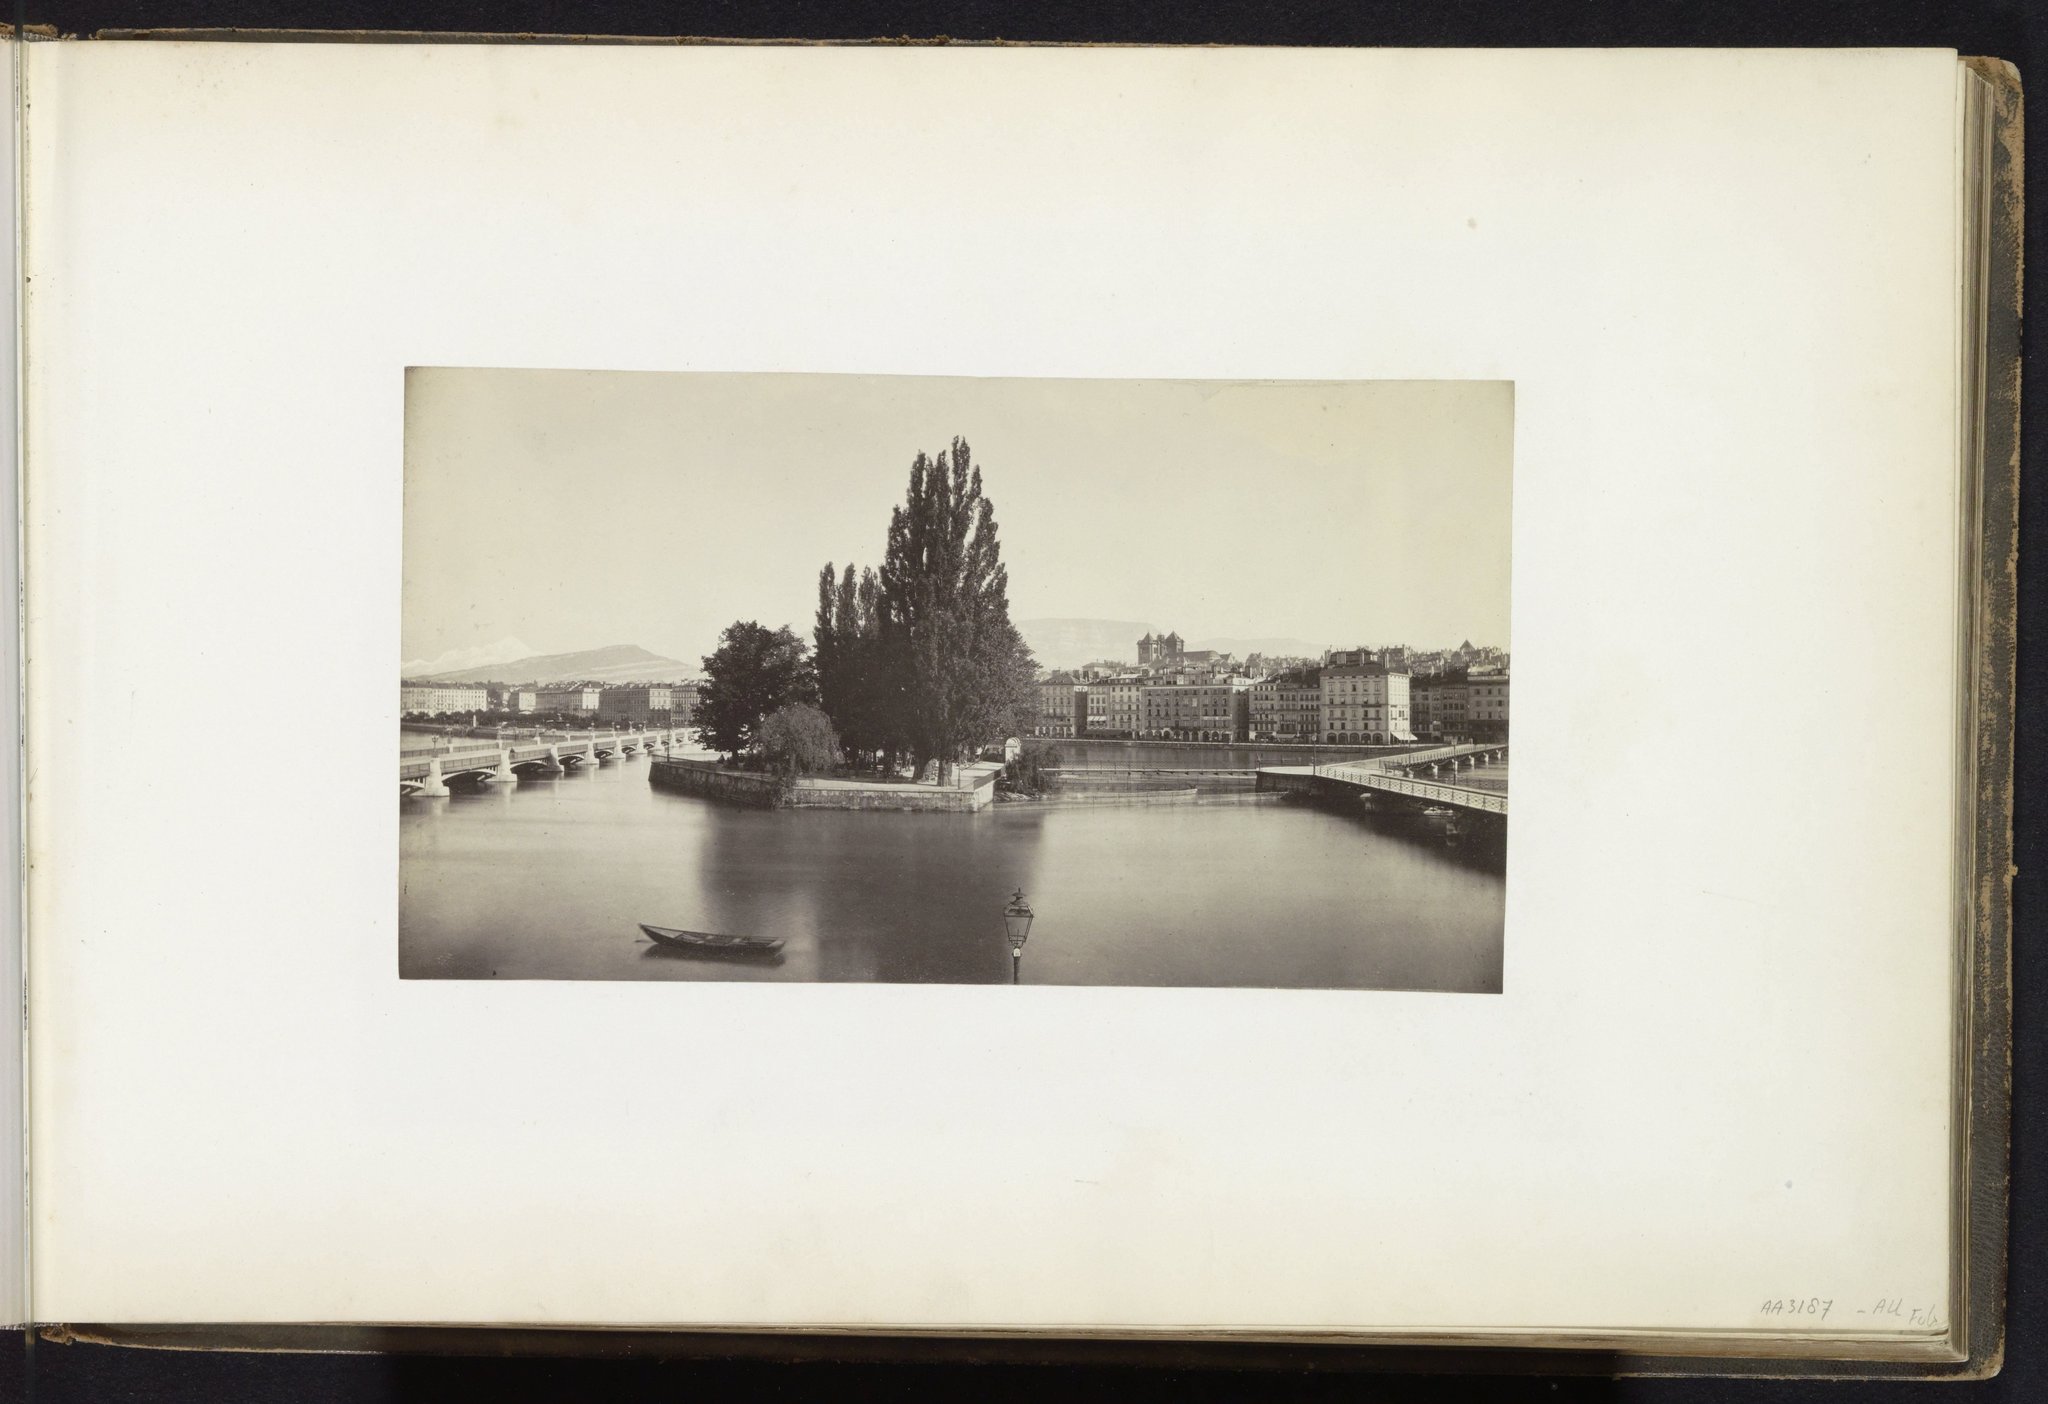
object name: photograph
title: Gezicht op Genève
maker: Anonymous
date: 1865-1875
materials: paper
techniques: albumen print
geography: geneva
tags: bridge in city across river, canal, etc., prospect of city, town panorama, silhouette of city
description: Onderdeel van Reisalbum met opnames van bezienswaardigheden in India, Duitsland, Zwitserland en Frankrijk.